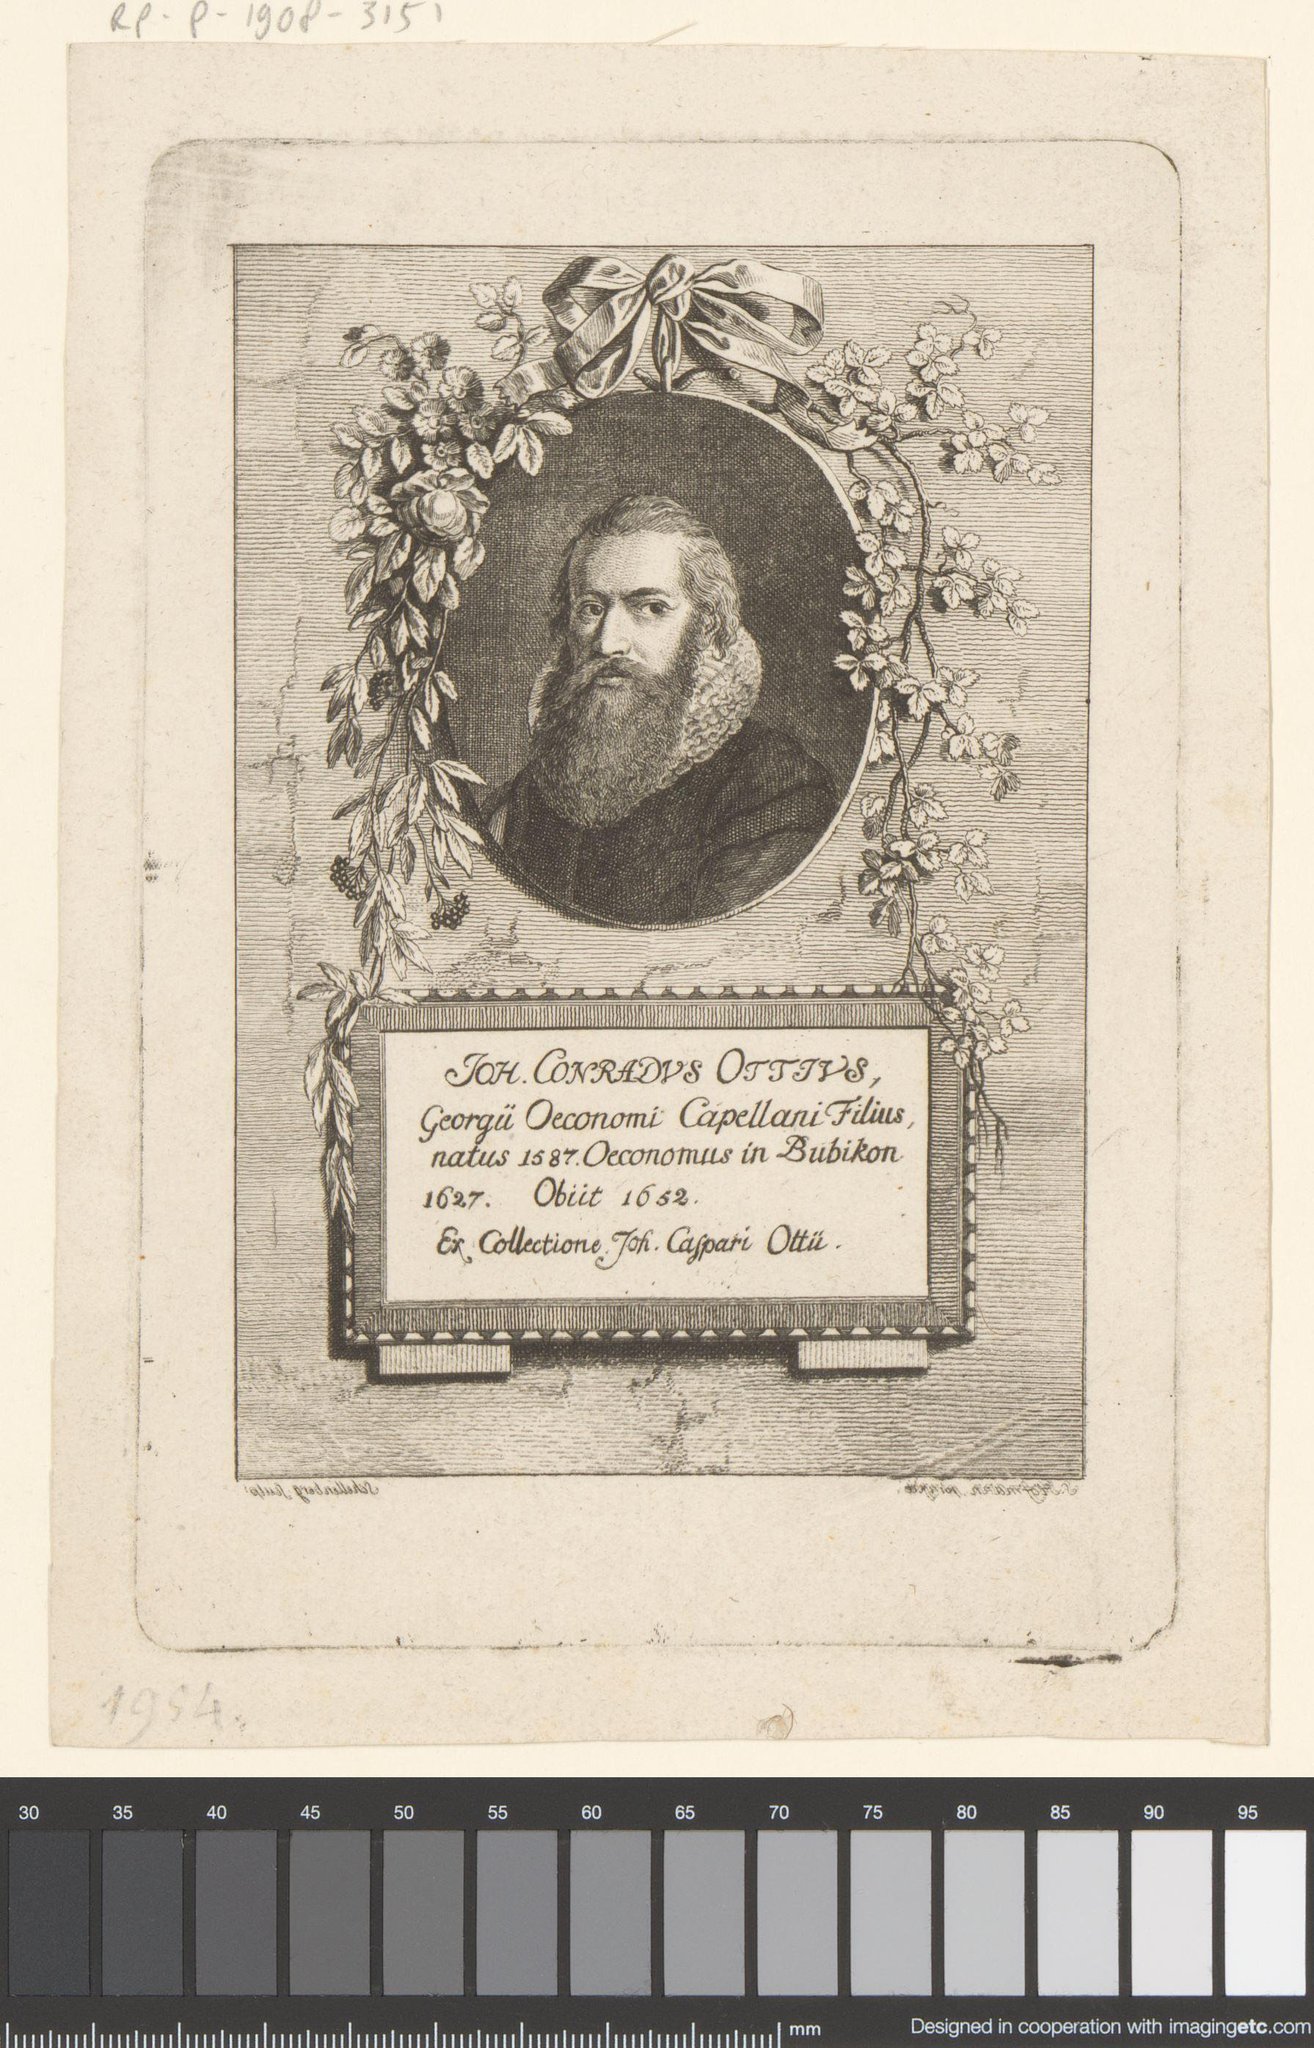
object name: print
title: Portret van Johann Konrad Ott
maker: johann rudolph schellenberg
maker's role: print maker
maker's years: 1740-1806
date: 1750-1806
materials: paper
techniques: etching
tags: politician, historical persons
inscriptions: collector's mark: Lugt 2228